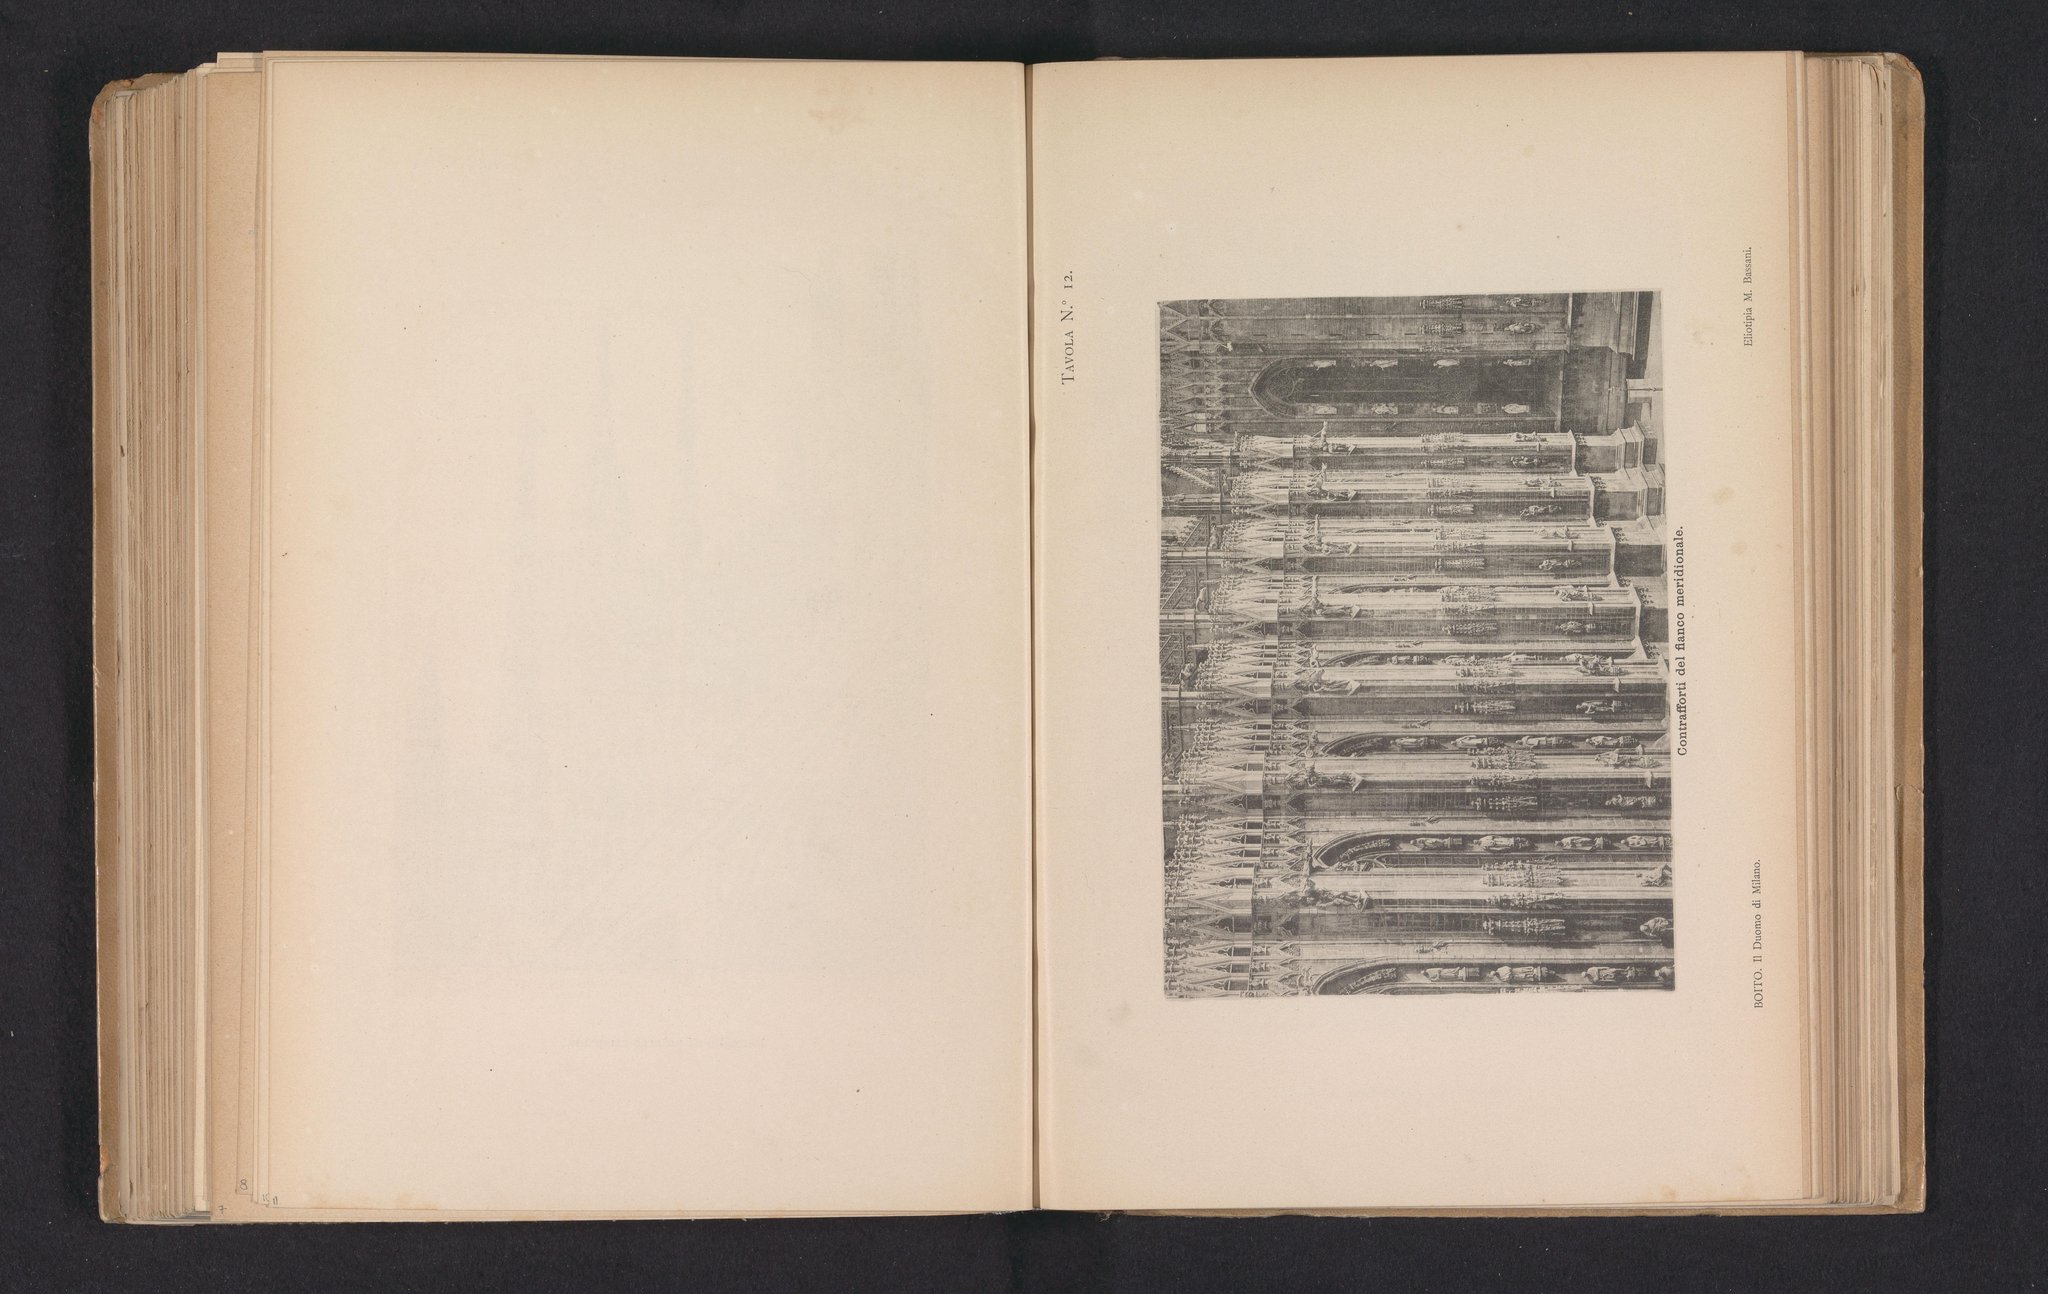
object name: page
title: Gezicht op steunberen van de zuidkant van de Dom van Milaan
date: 1879-1889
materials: paper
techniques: photograph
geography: milan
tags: piece of sculpture, reproduction of a piece of sculpture, parts of church exterior and annexes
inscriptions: number: ‘Tavola No. 12.’